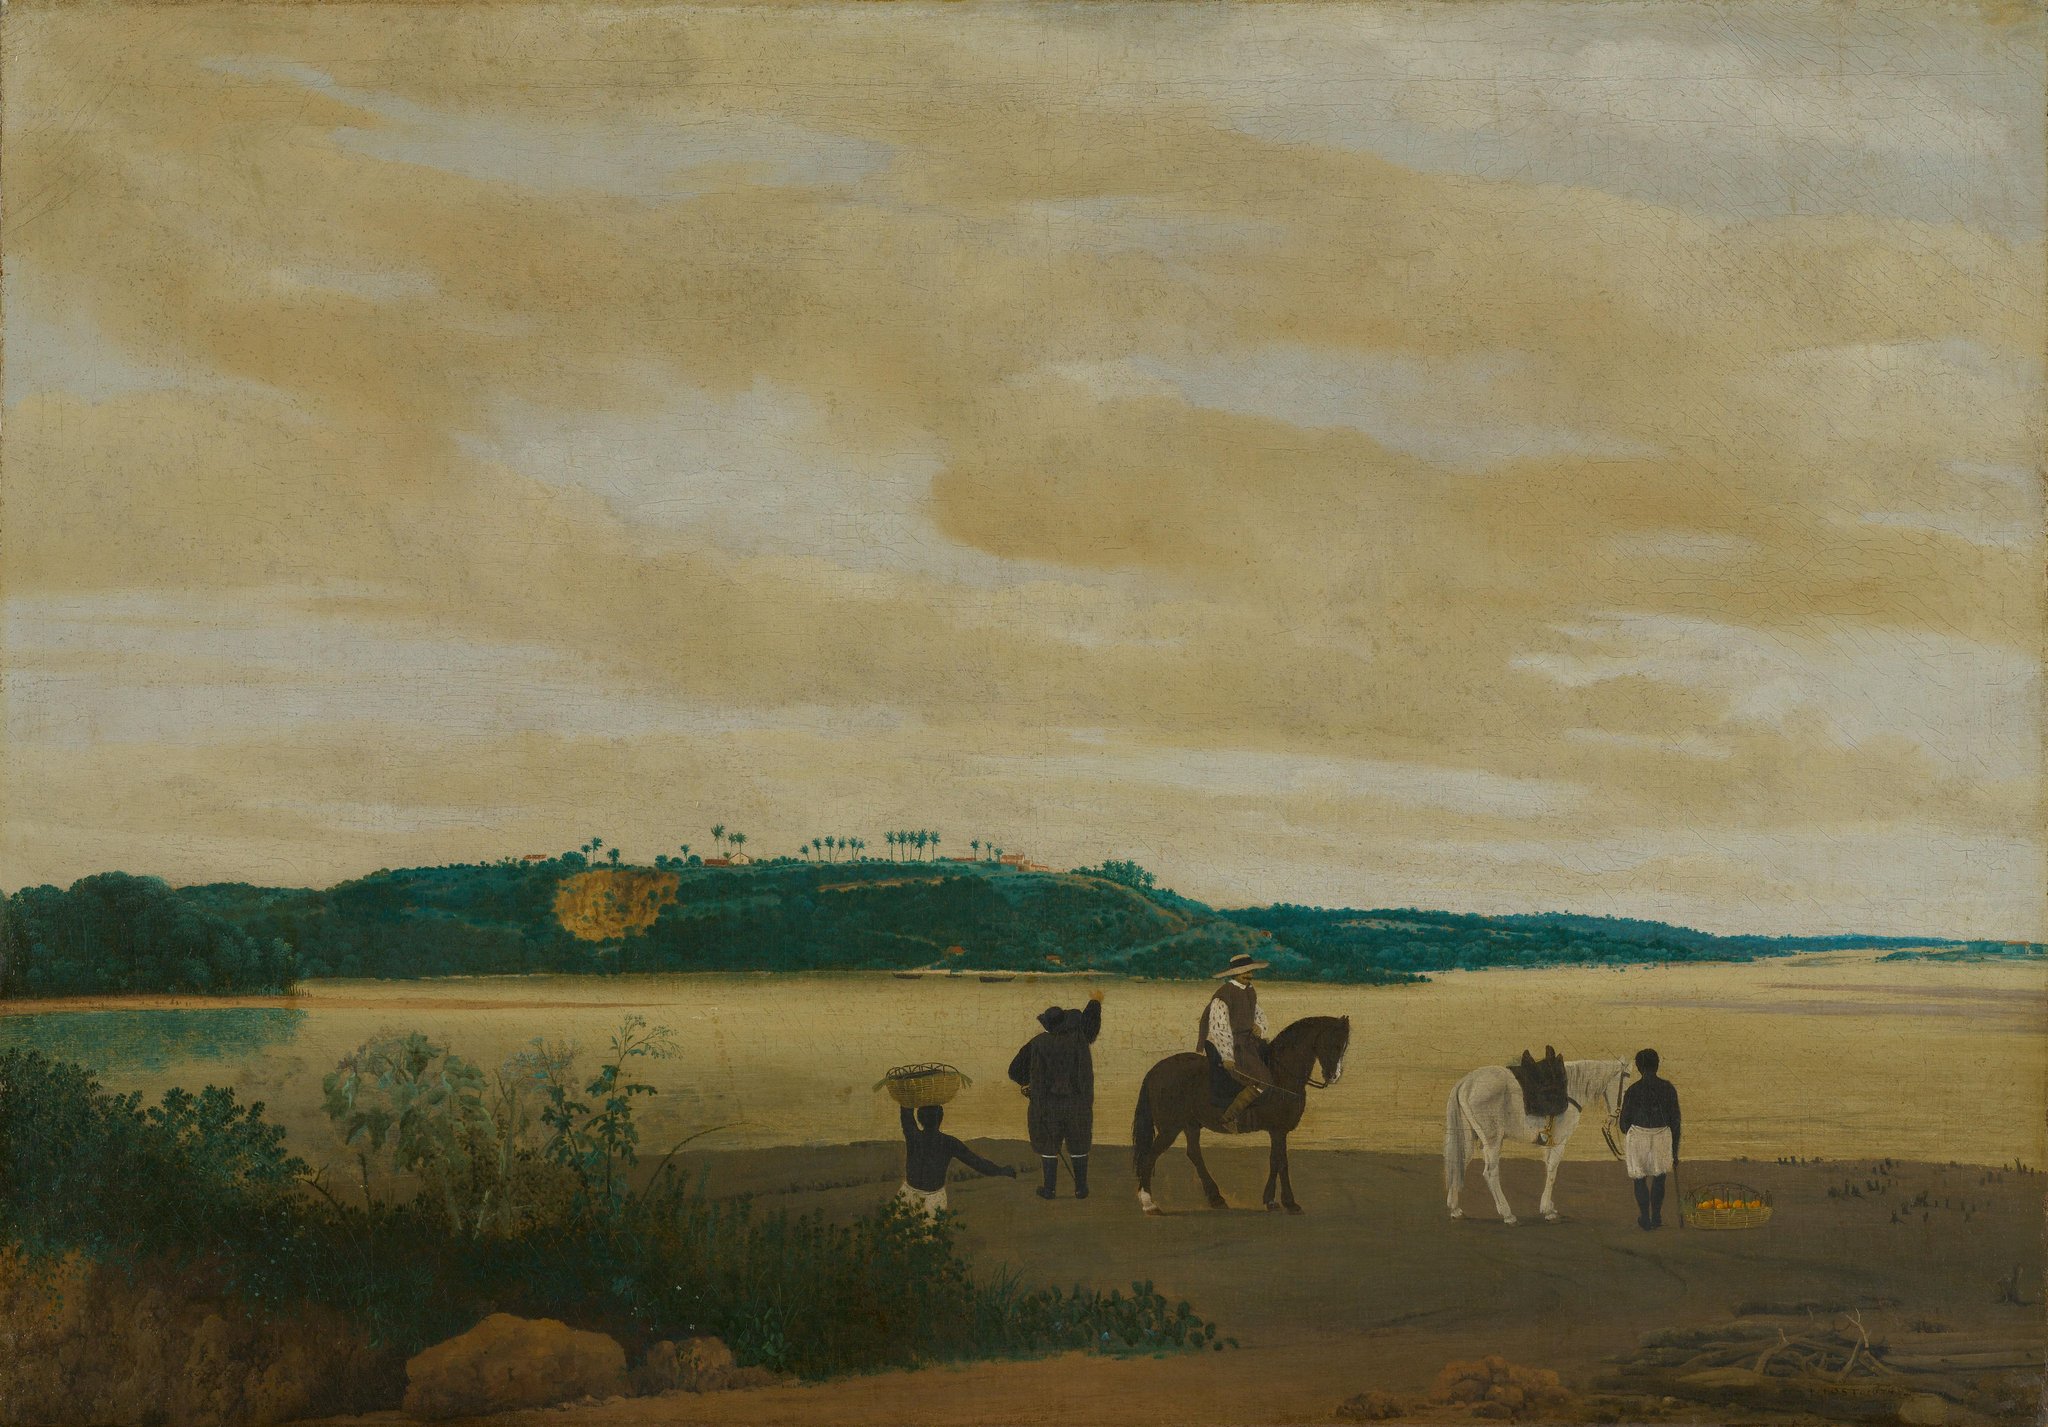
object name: painting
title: View of the Island of Itamaracá, Brazil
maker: frans jansz post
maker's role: painter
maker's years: 1612-1680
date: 1637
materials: canvas, oil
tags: fortress, landscapes in tropical and sub-tropical regions, brasil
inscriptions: signature and date: ‘F. Post 1637 D3’, inscription: ‘Het Eijlant I. Tamaraca gelijck hetselve int Zuijden verthoont, de stadt legt boven op de Berg beneden is het Fort Orangien; het welcke leit inden mont van de Zee, op dese manier sitten de Portugisen de peert.’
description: This is the earliest known painting of Post, made on 3 November 1637. At first Johan Maurits wanted to build the new capital on the island of Itamaracá. The group of men, including two enslaved, in the foreground are probably exploring the island. On the hill across the water lies Schoppestad, with on the right Fort Oranje, which can still be visited today.